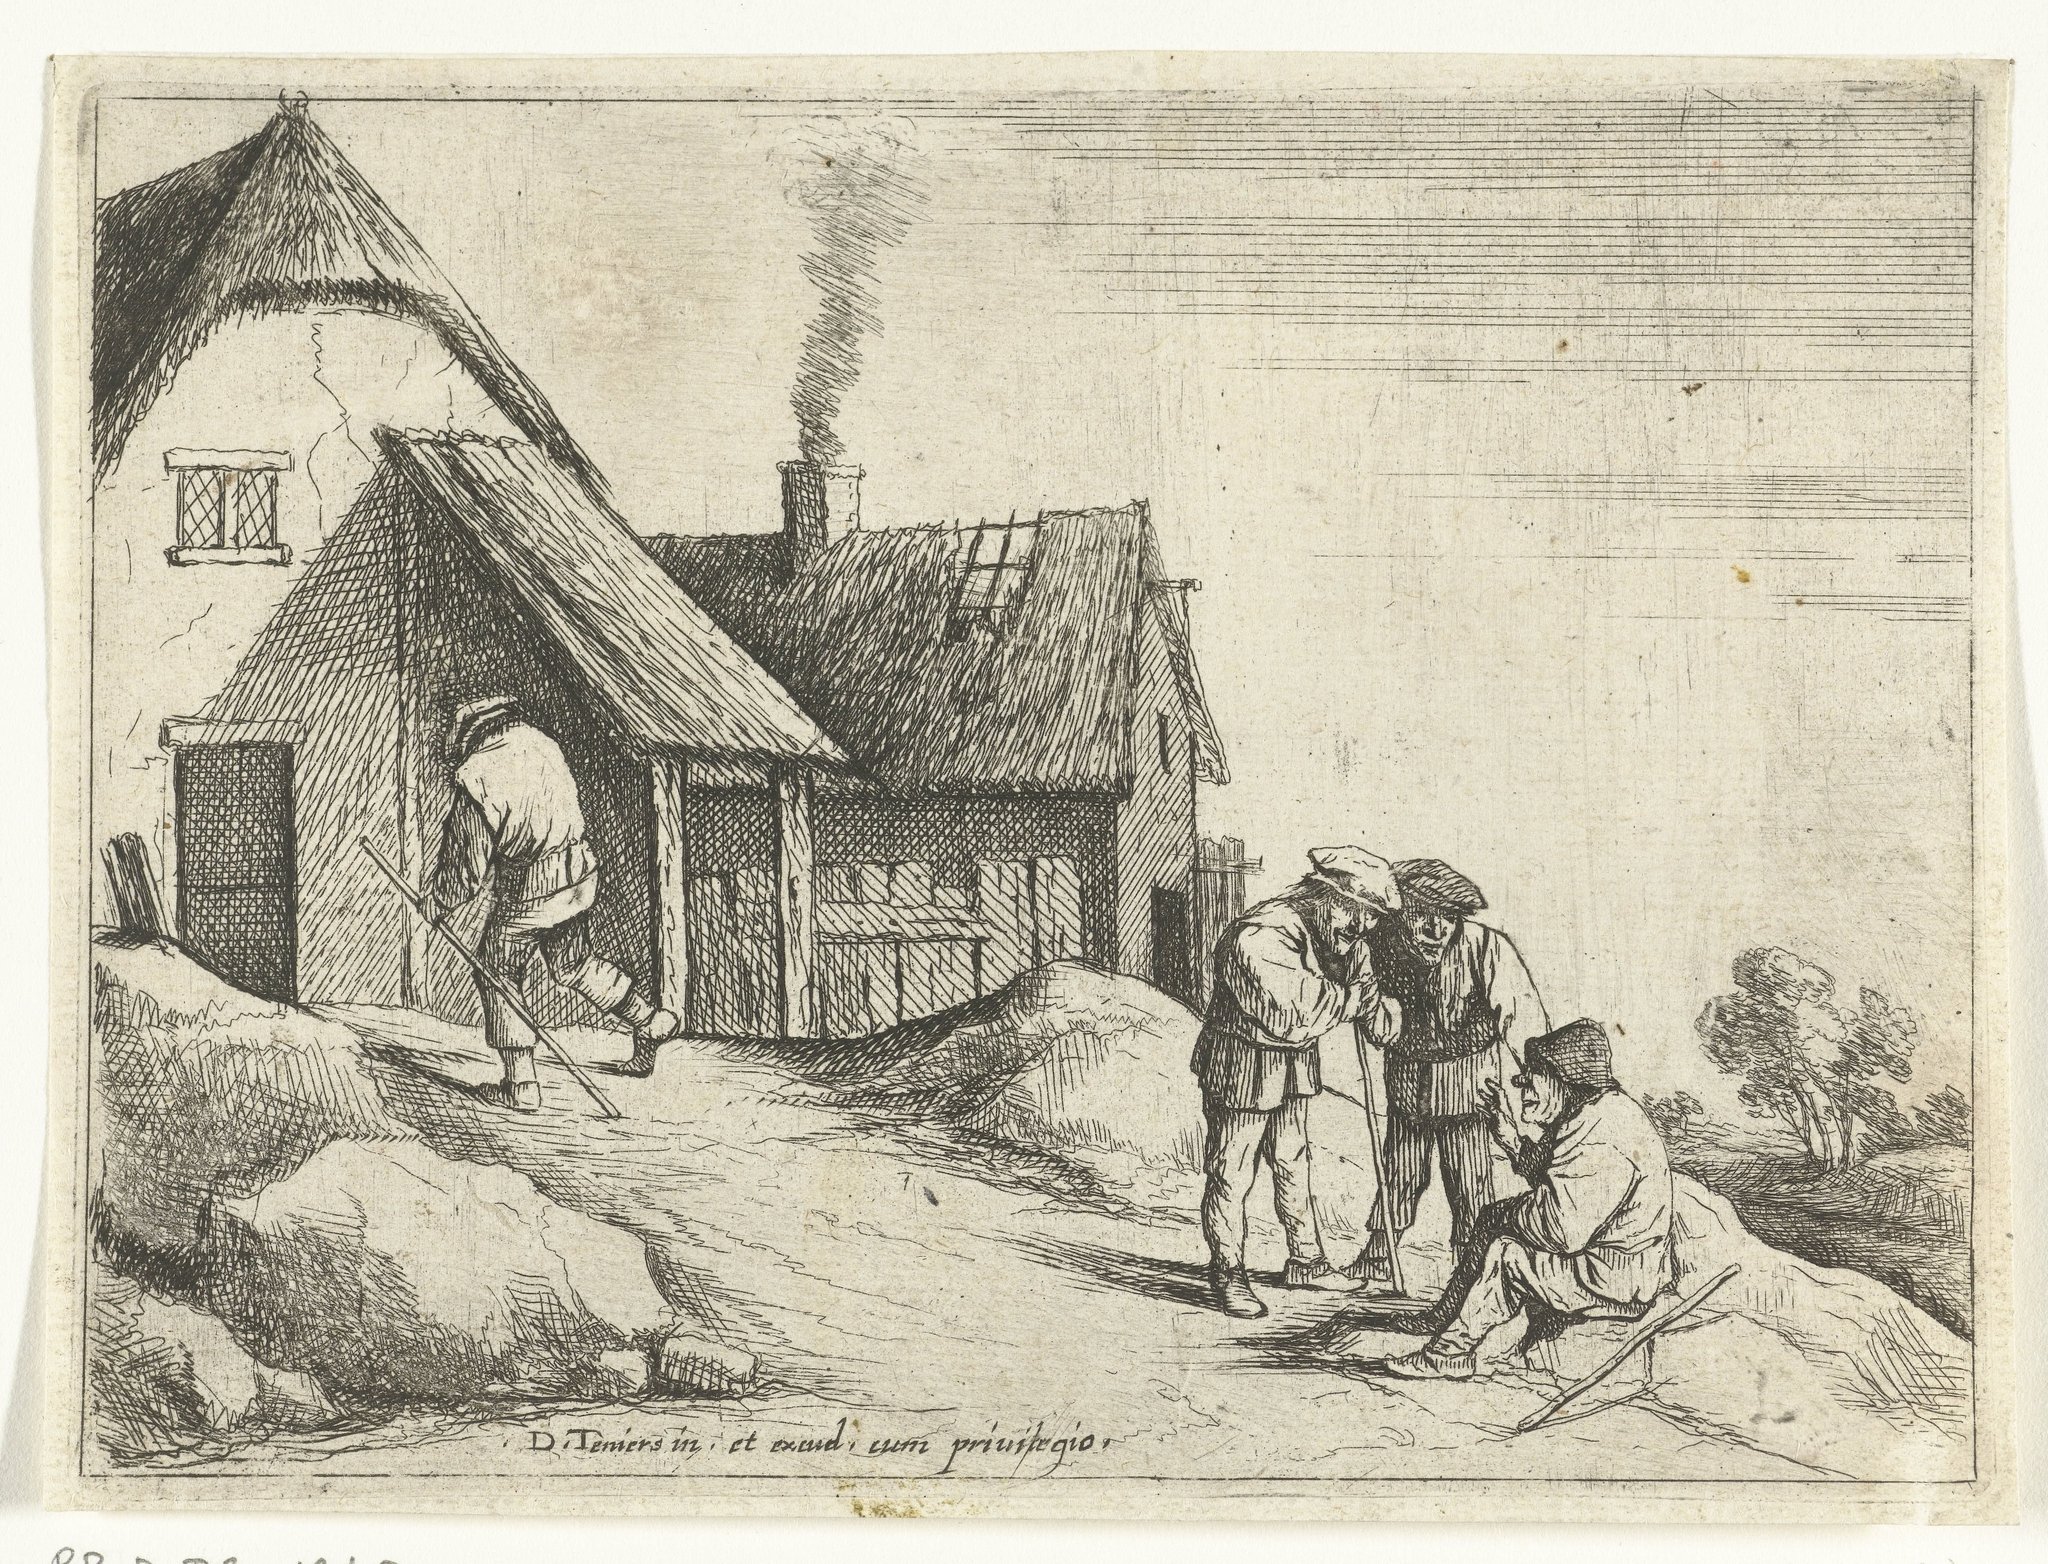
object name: print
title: Wandelaars bij een boerenerf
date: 1635-1668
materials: paper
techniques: etching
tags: hotel, hostelry, inn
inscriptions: collector's mark: Lugt 240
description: Drie wandelaars rusten uit langs de weg bij een boerenerf. Een vierde man loopt naar het huis toe.